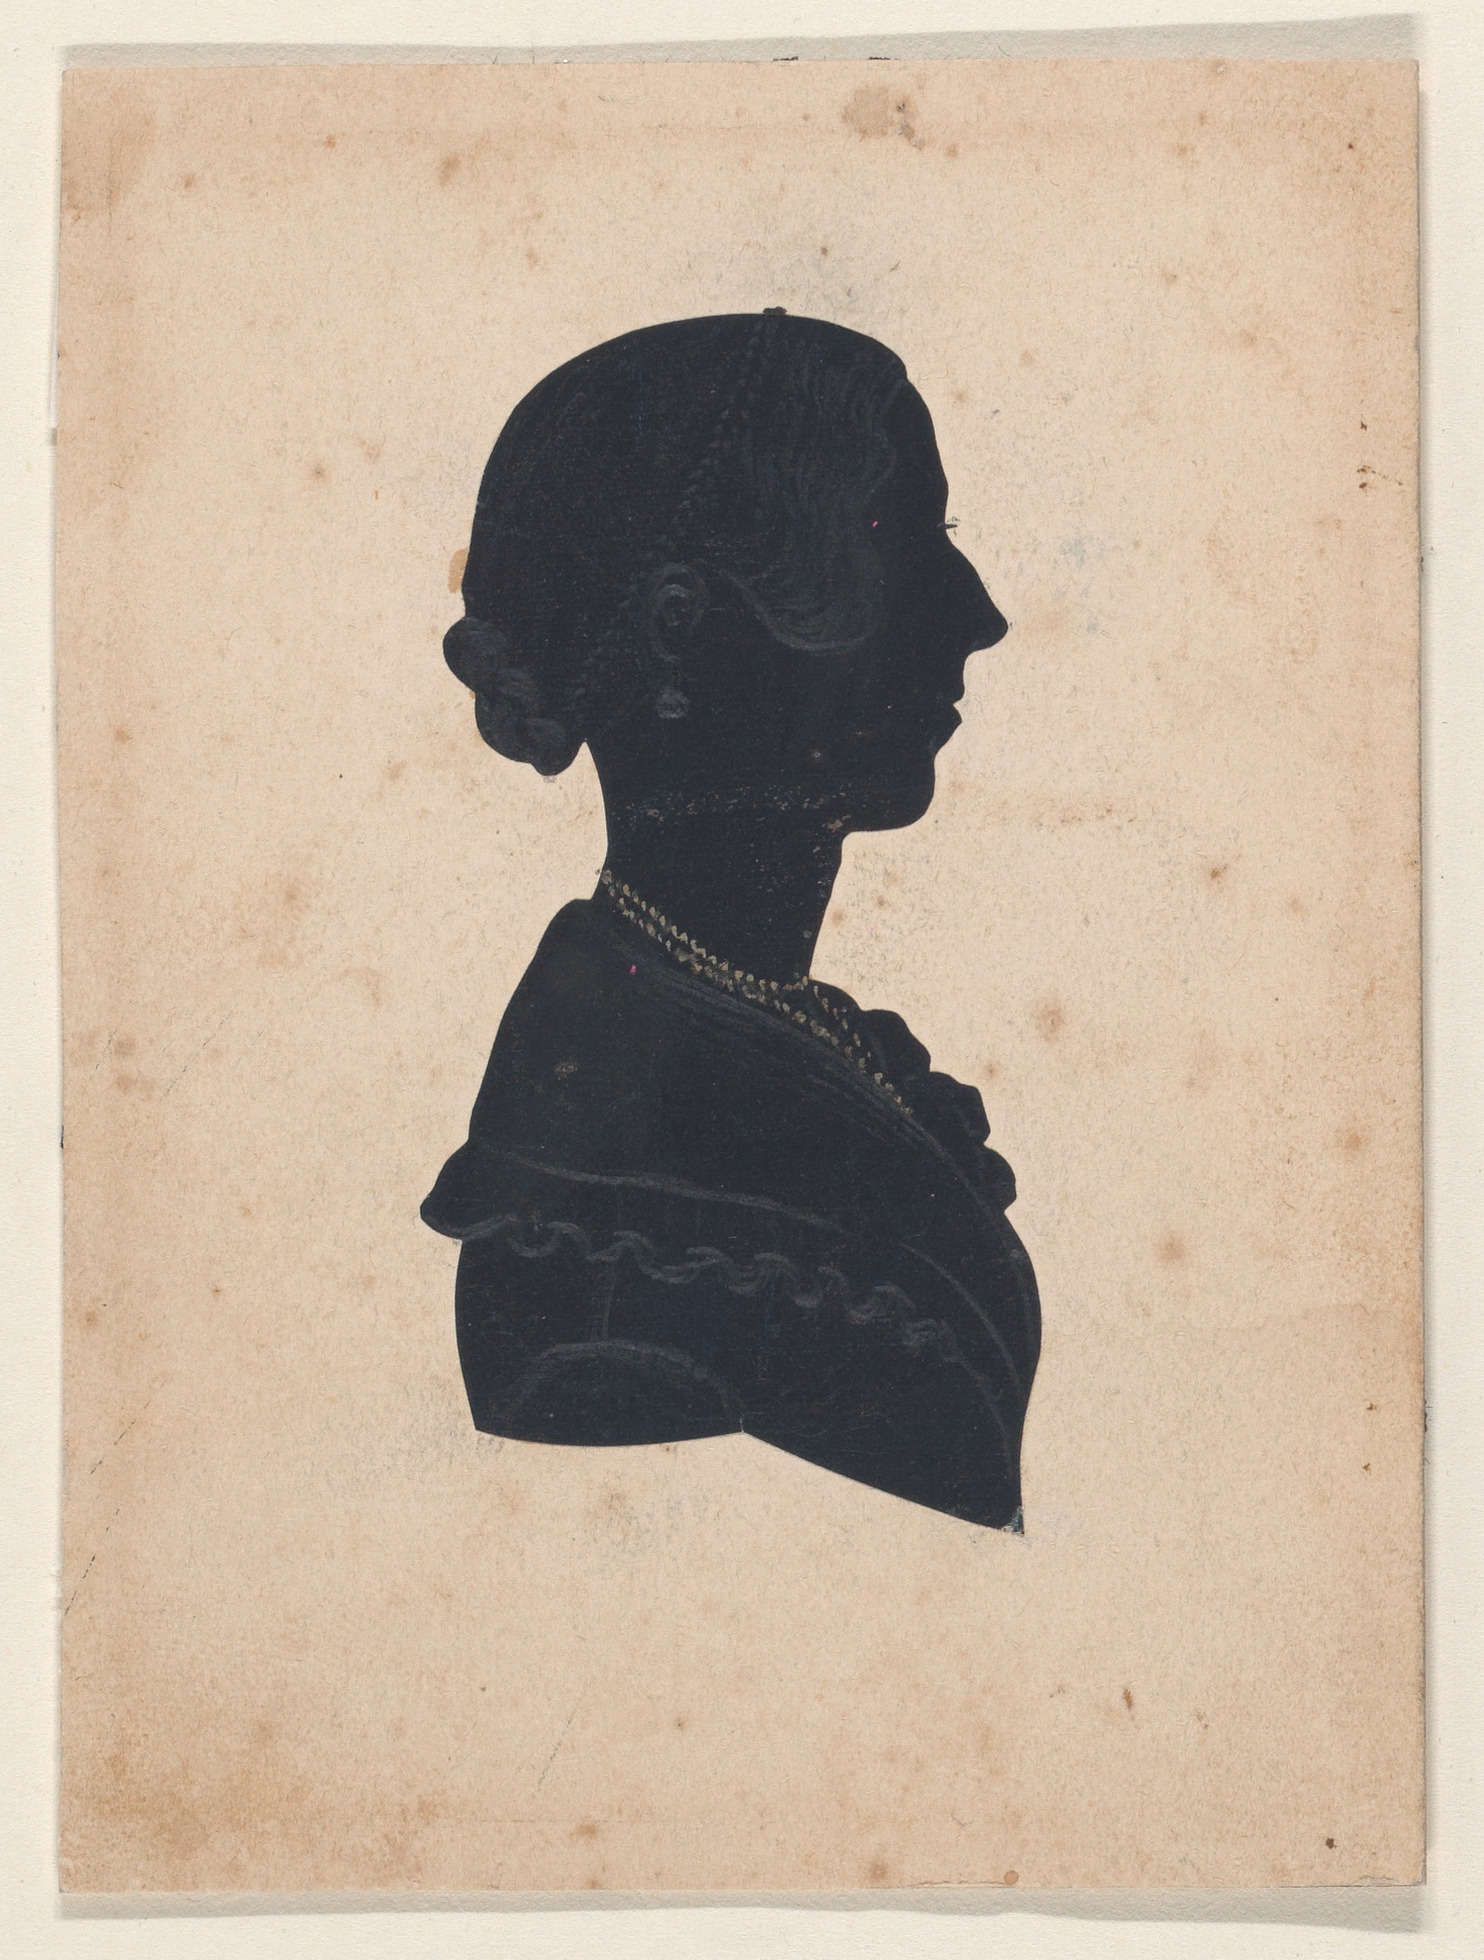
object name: cut paper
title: Silhouette of a man facing left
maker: rufus k. cummings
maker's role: artist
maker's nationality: american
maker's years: 1800-1900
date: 1843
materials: graphite, paper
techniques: cutting, heightening